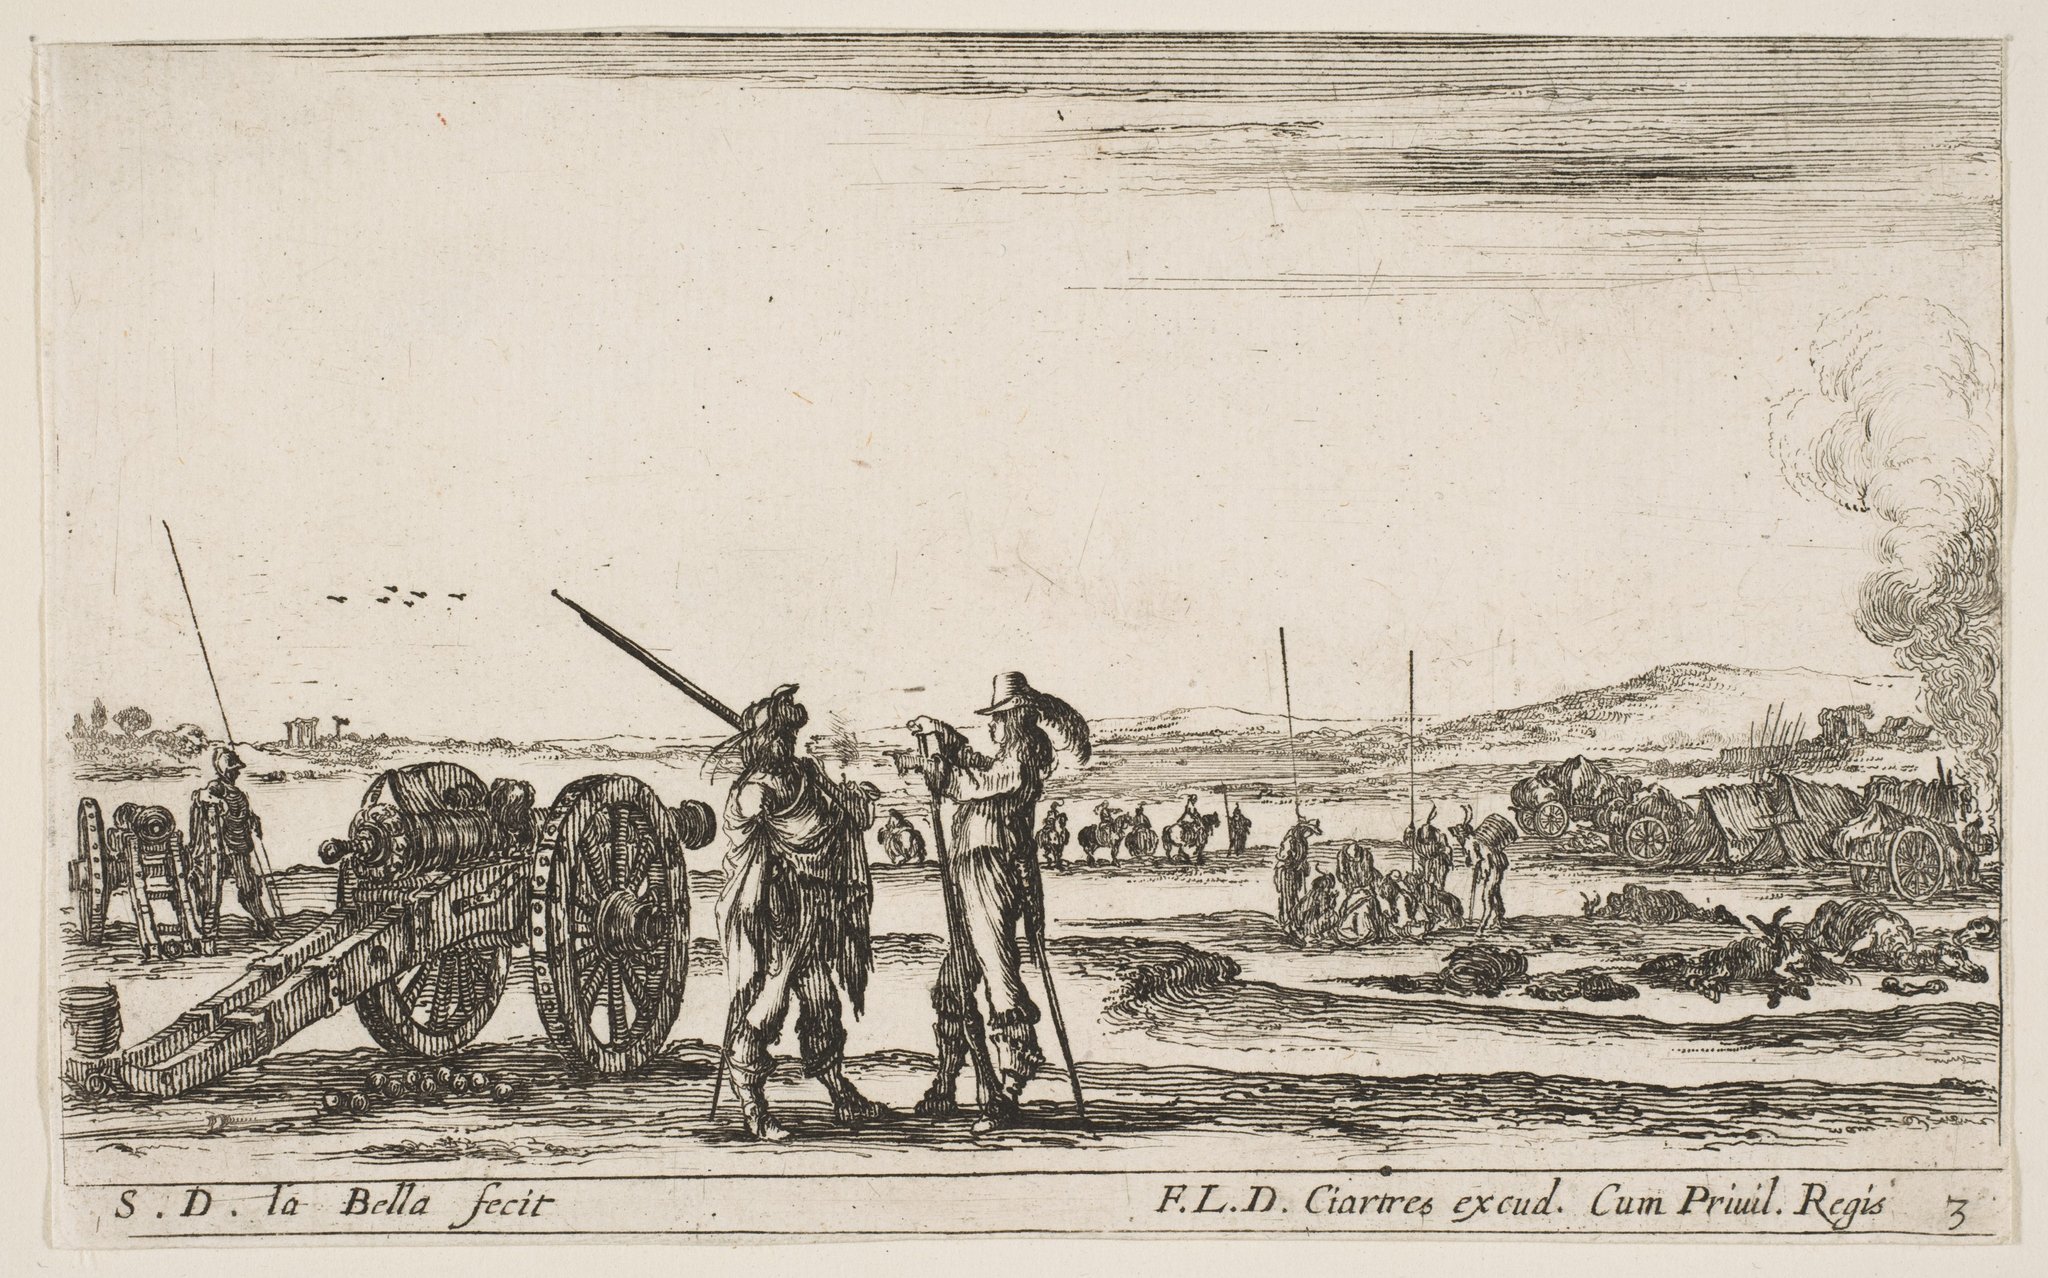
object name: print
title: An officer giving orders to a soldier in centre foreground, cannon at left, plate 3 from "Various Military Caprices" (Varii capricci militari)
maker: stefano della bella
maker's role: artist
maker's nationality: italian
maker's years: 1610-1664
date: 1641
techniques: etching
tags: soldiers,cannons